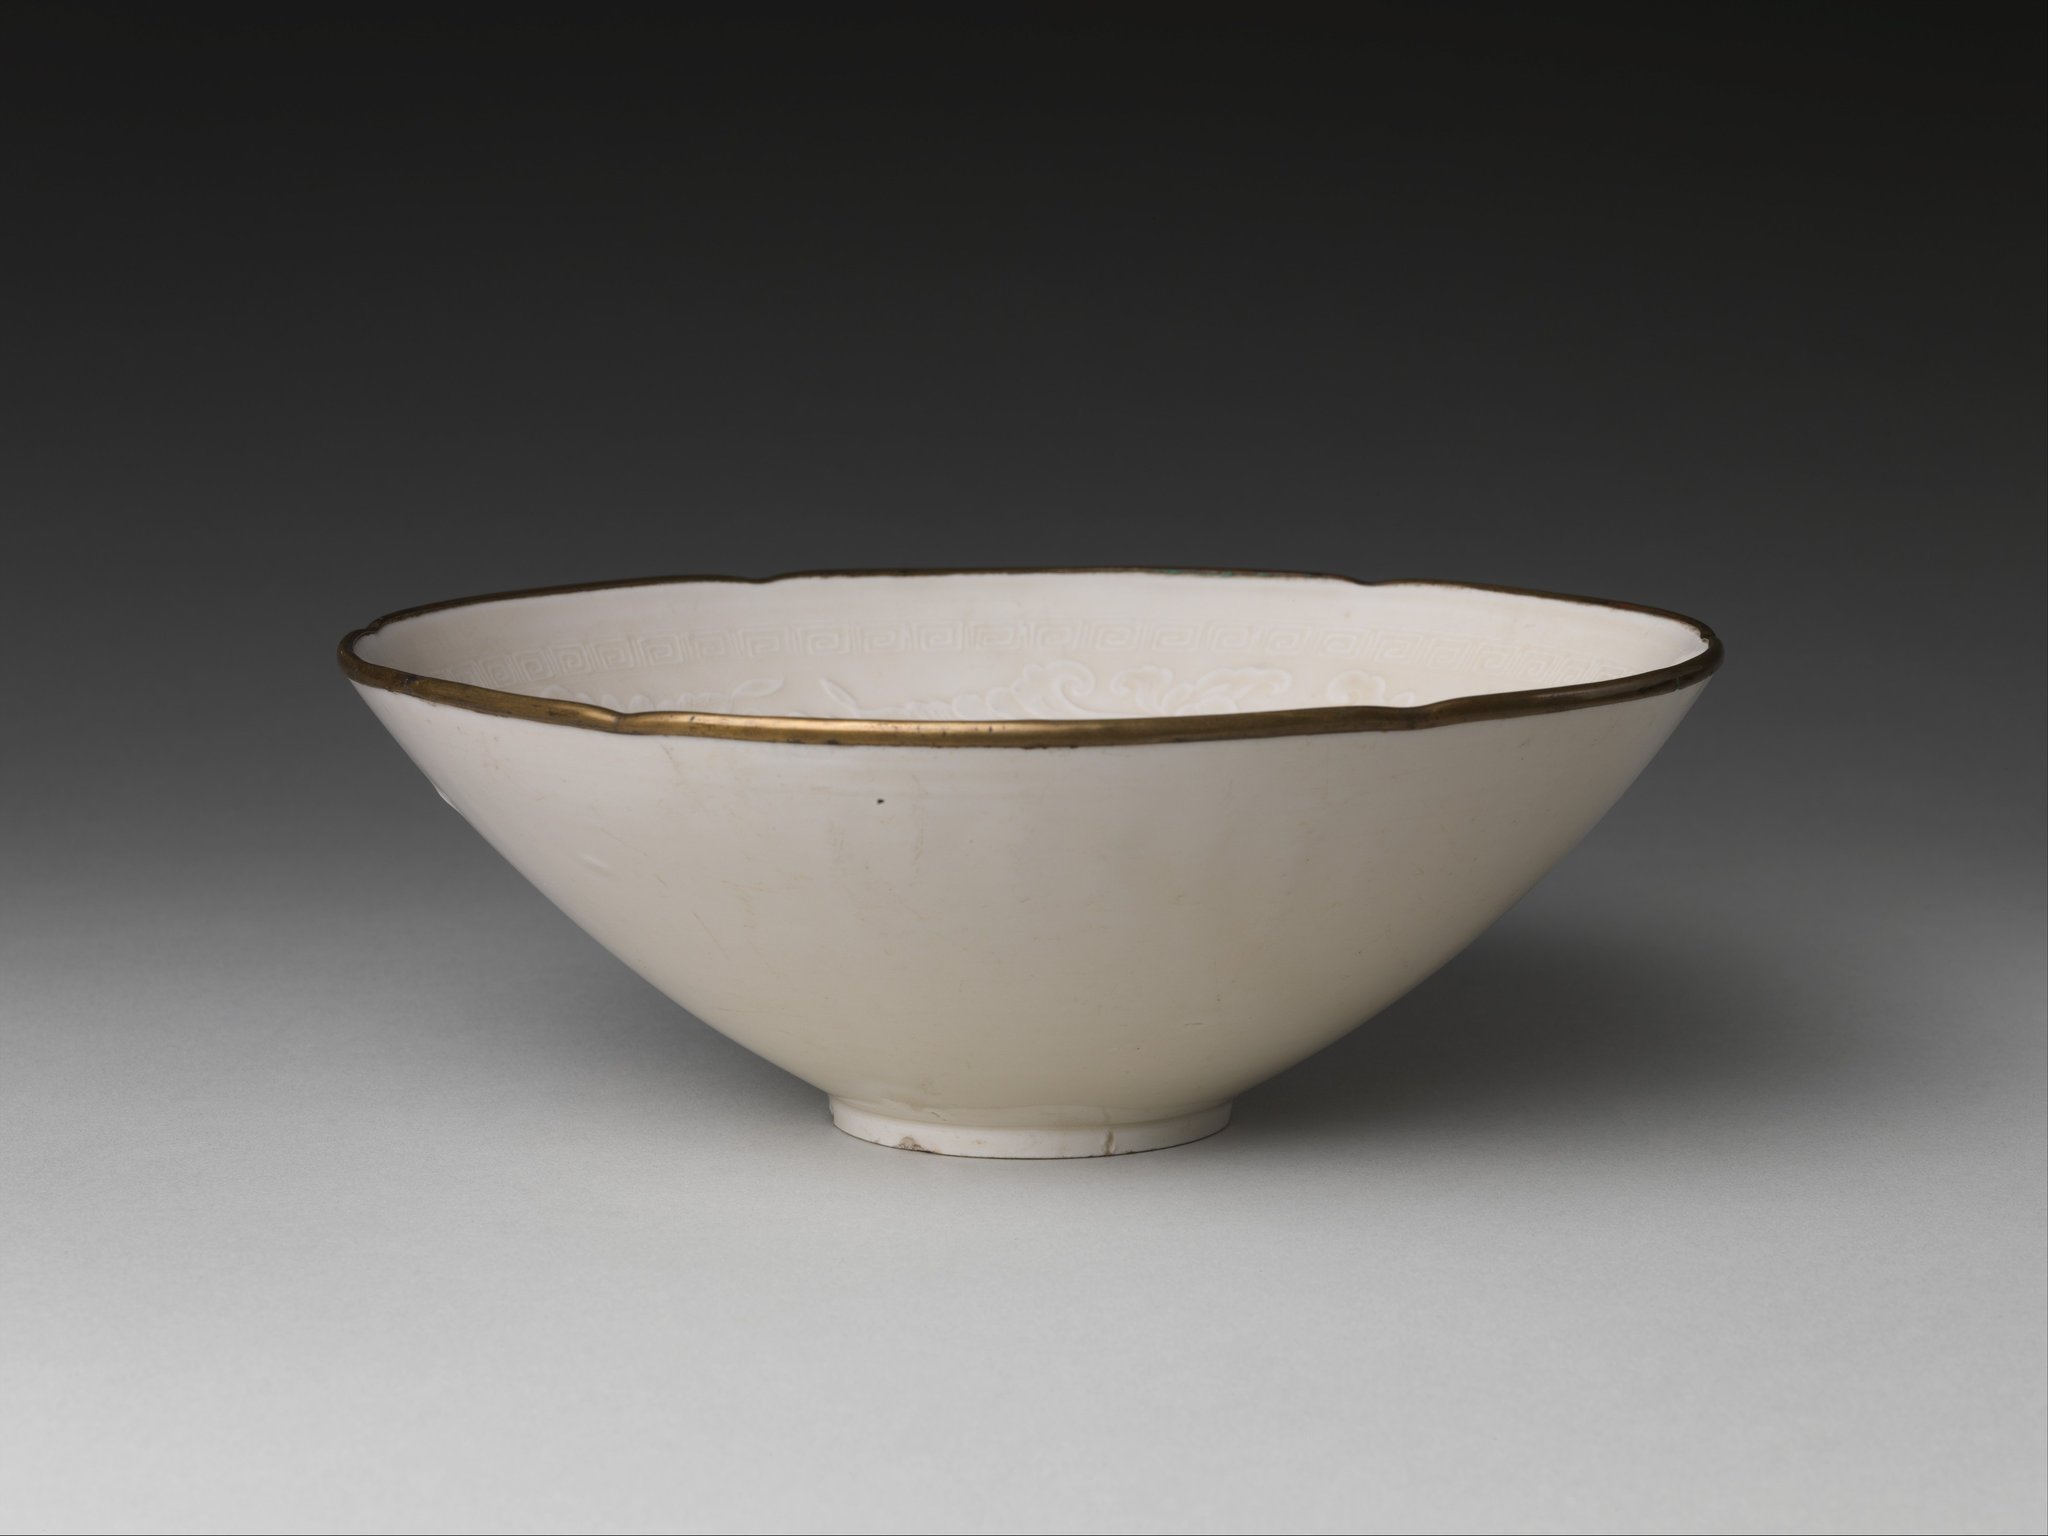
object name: bowl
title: Bowl with Peonies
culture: chinese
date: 1101-1300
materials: glaze, ivory, porcelain